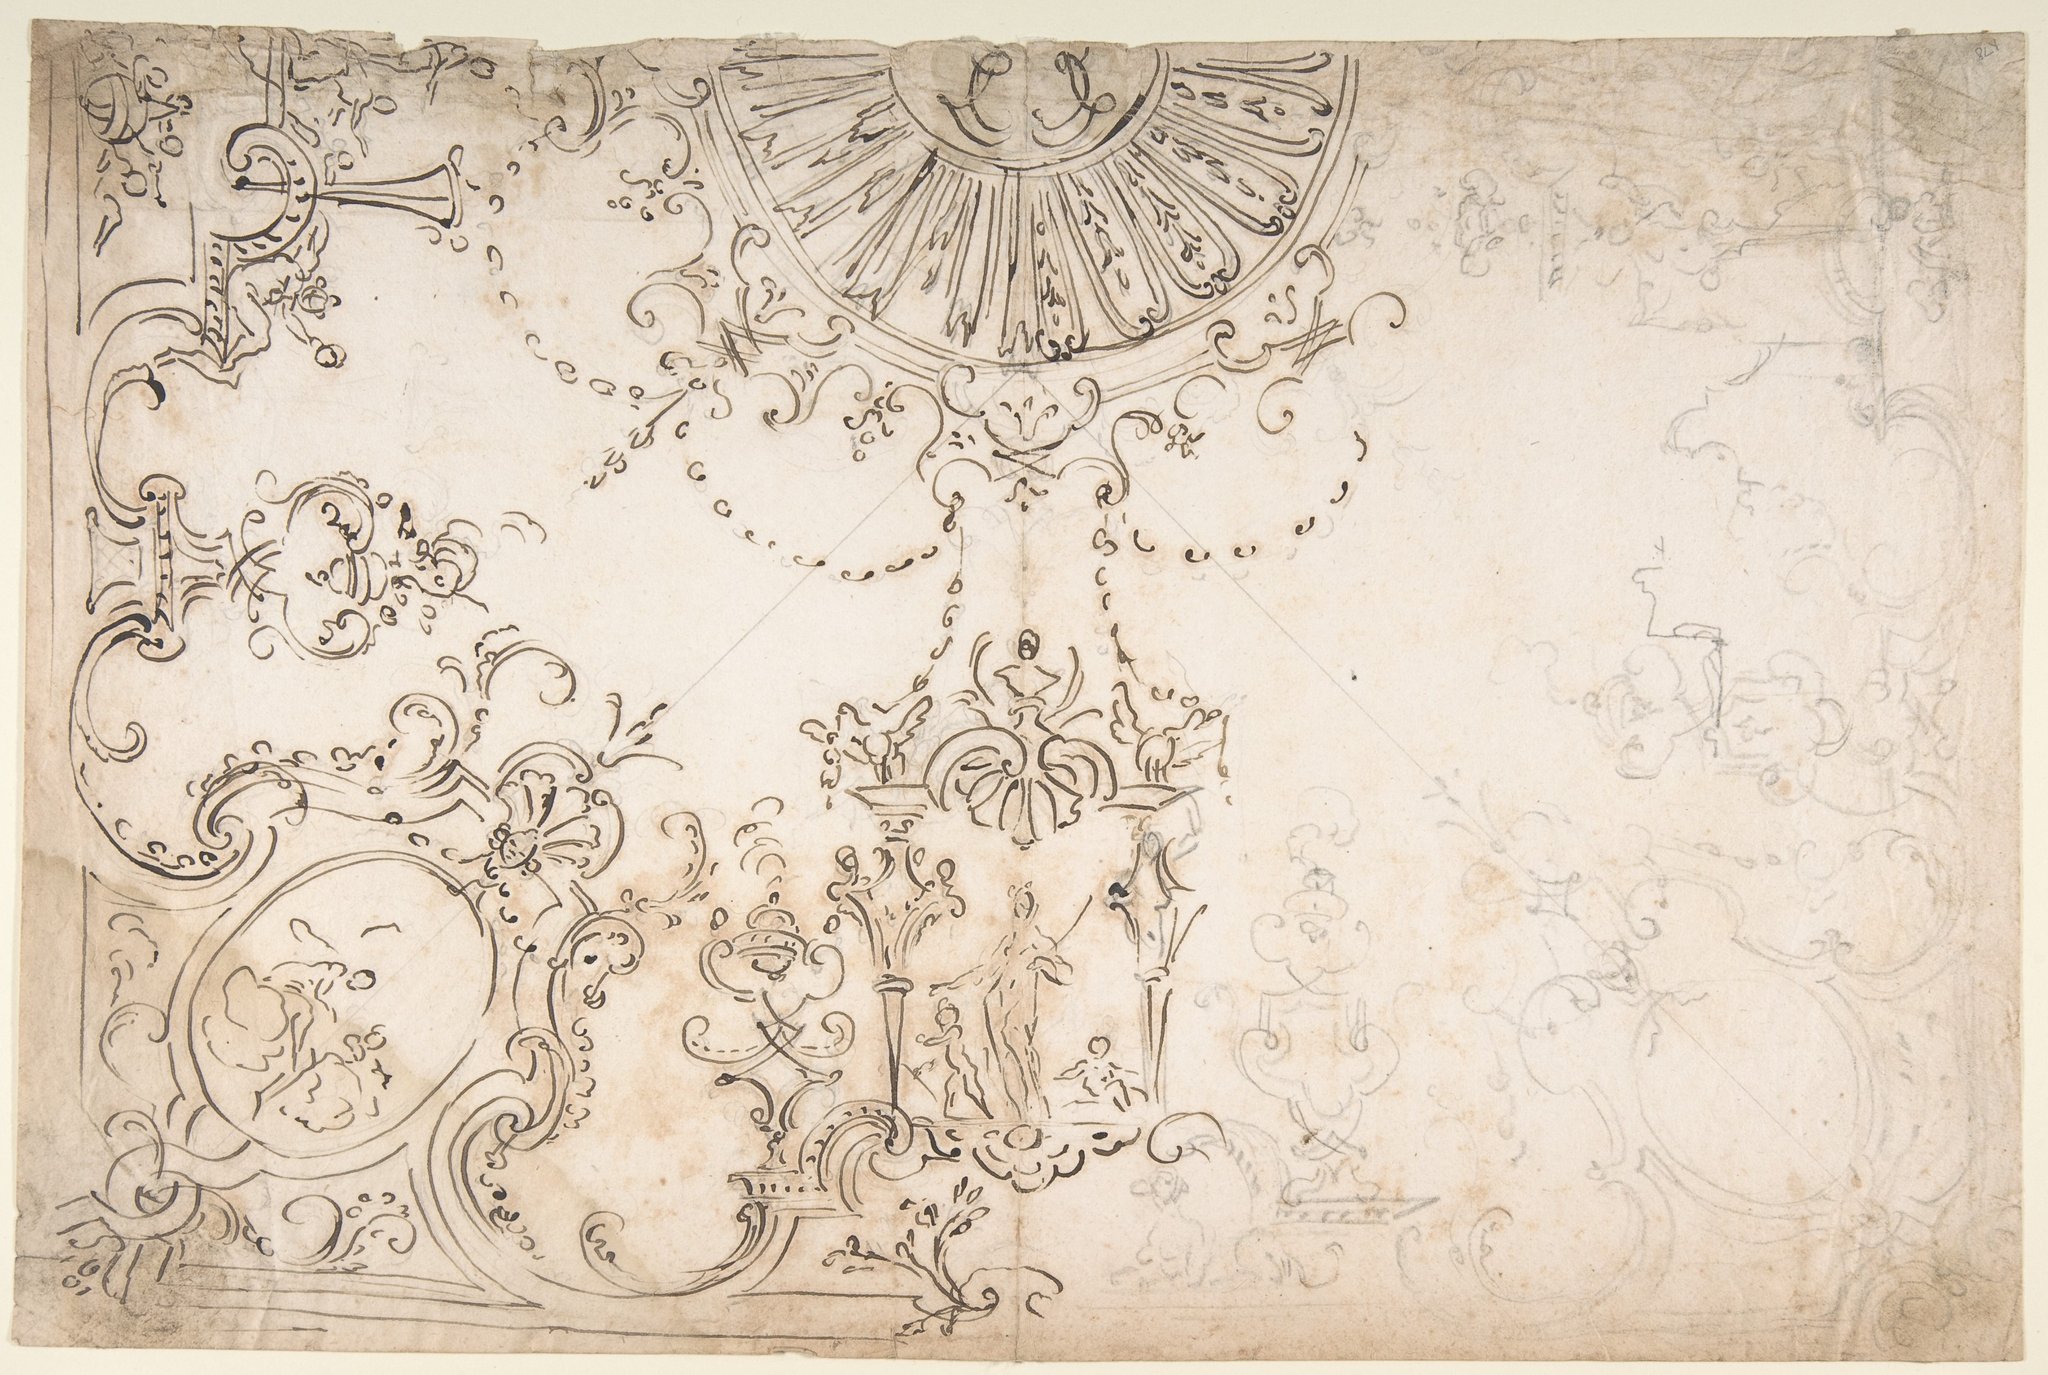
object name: drawing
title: Design for One Half of a Ceiling with Elaborate Medaillons and Figures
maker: donato giuseppe frisoni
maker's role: artist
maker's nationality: italian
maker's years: 1683-1735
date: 1709-1730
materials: graphite, ink, drawing material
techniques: pen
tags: ornament,ceilings